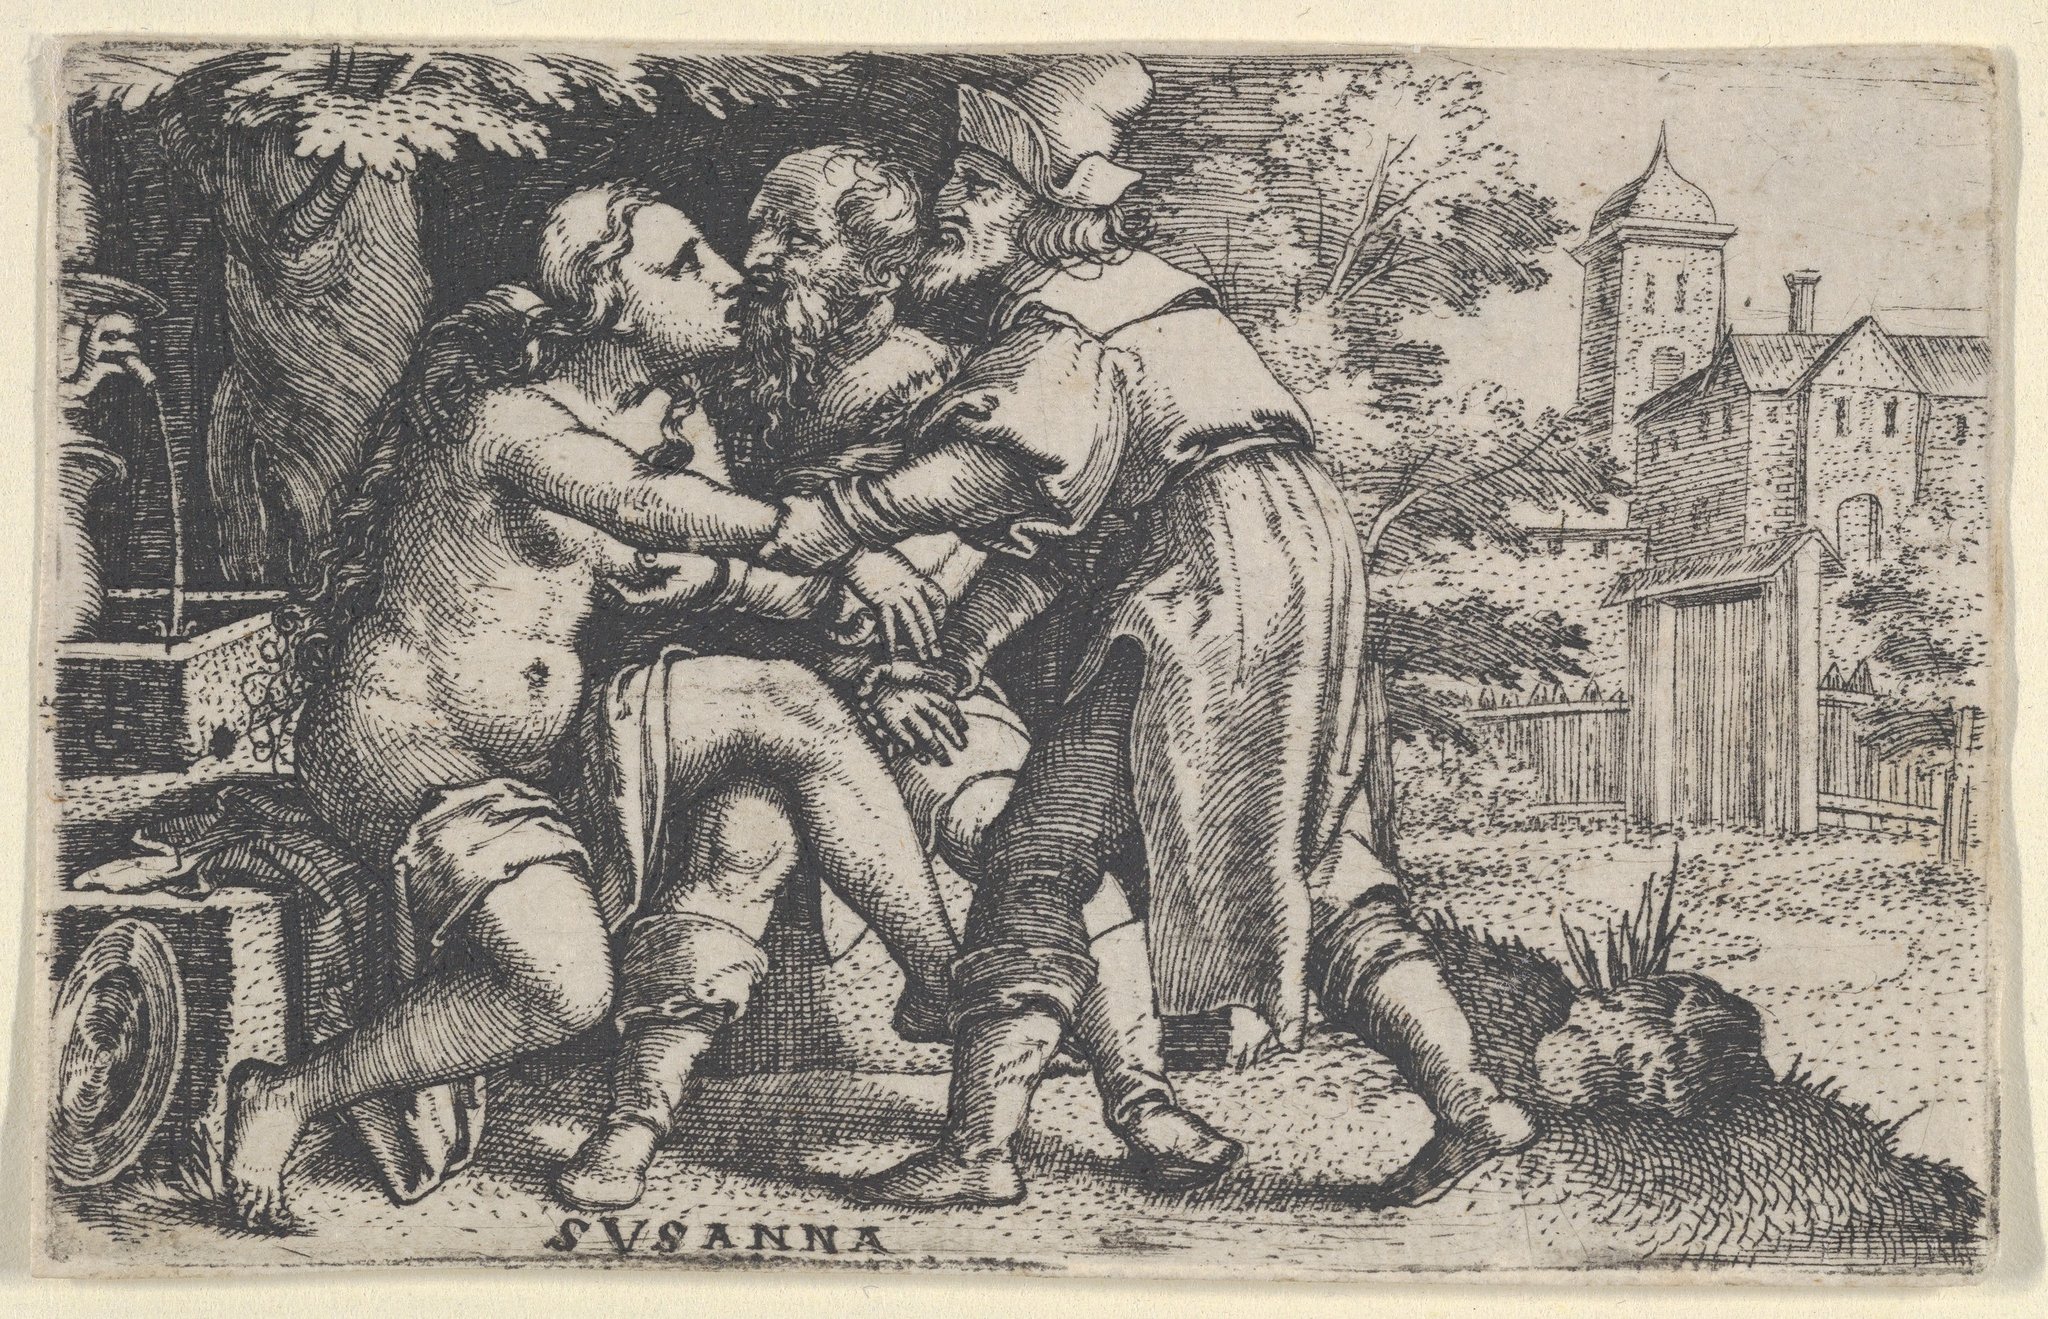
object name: print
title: Susanna and the Elders, from "Scenes from the Old Testament"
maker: georg pencz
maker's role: artist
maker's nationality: german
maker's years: 1500-1550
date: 1526-1536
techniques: engraving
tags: buildings,men,female nudes